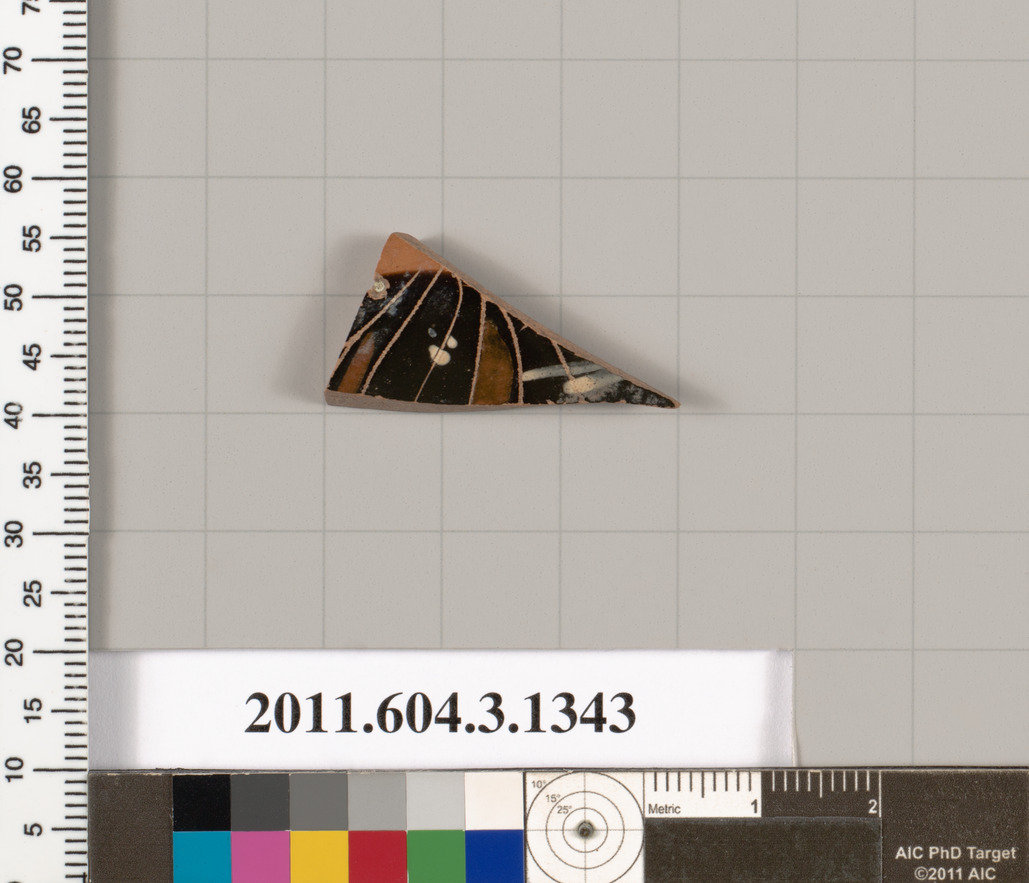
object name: skyphos fragment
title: Terracotta fragment of a skyphos (deep drinking cup)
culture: greek, attic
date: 500-468 BCE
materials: terracotta